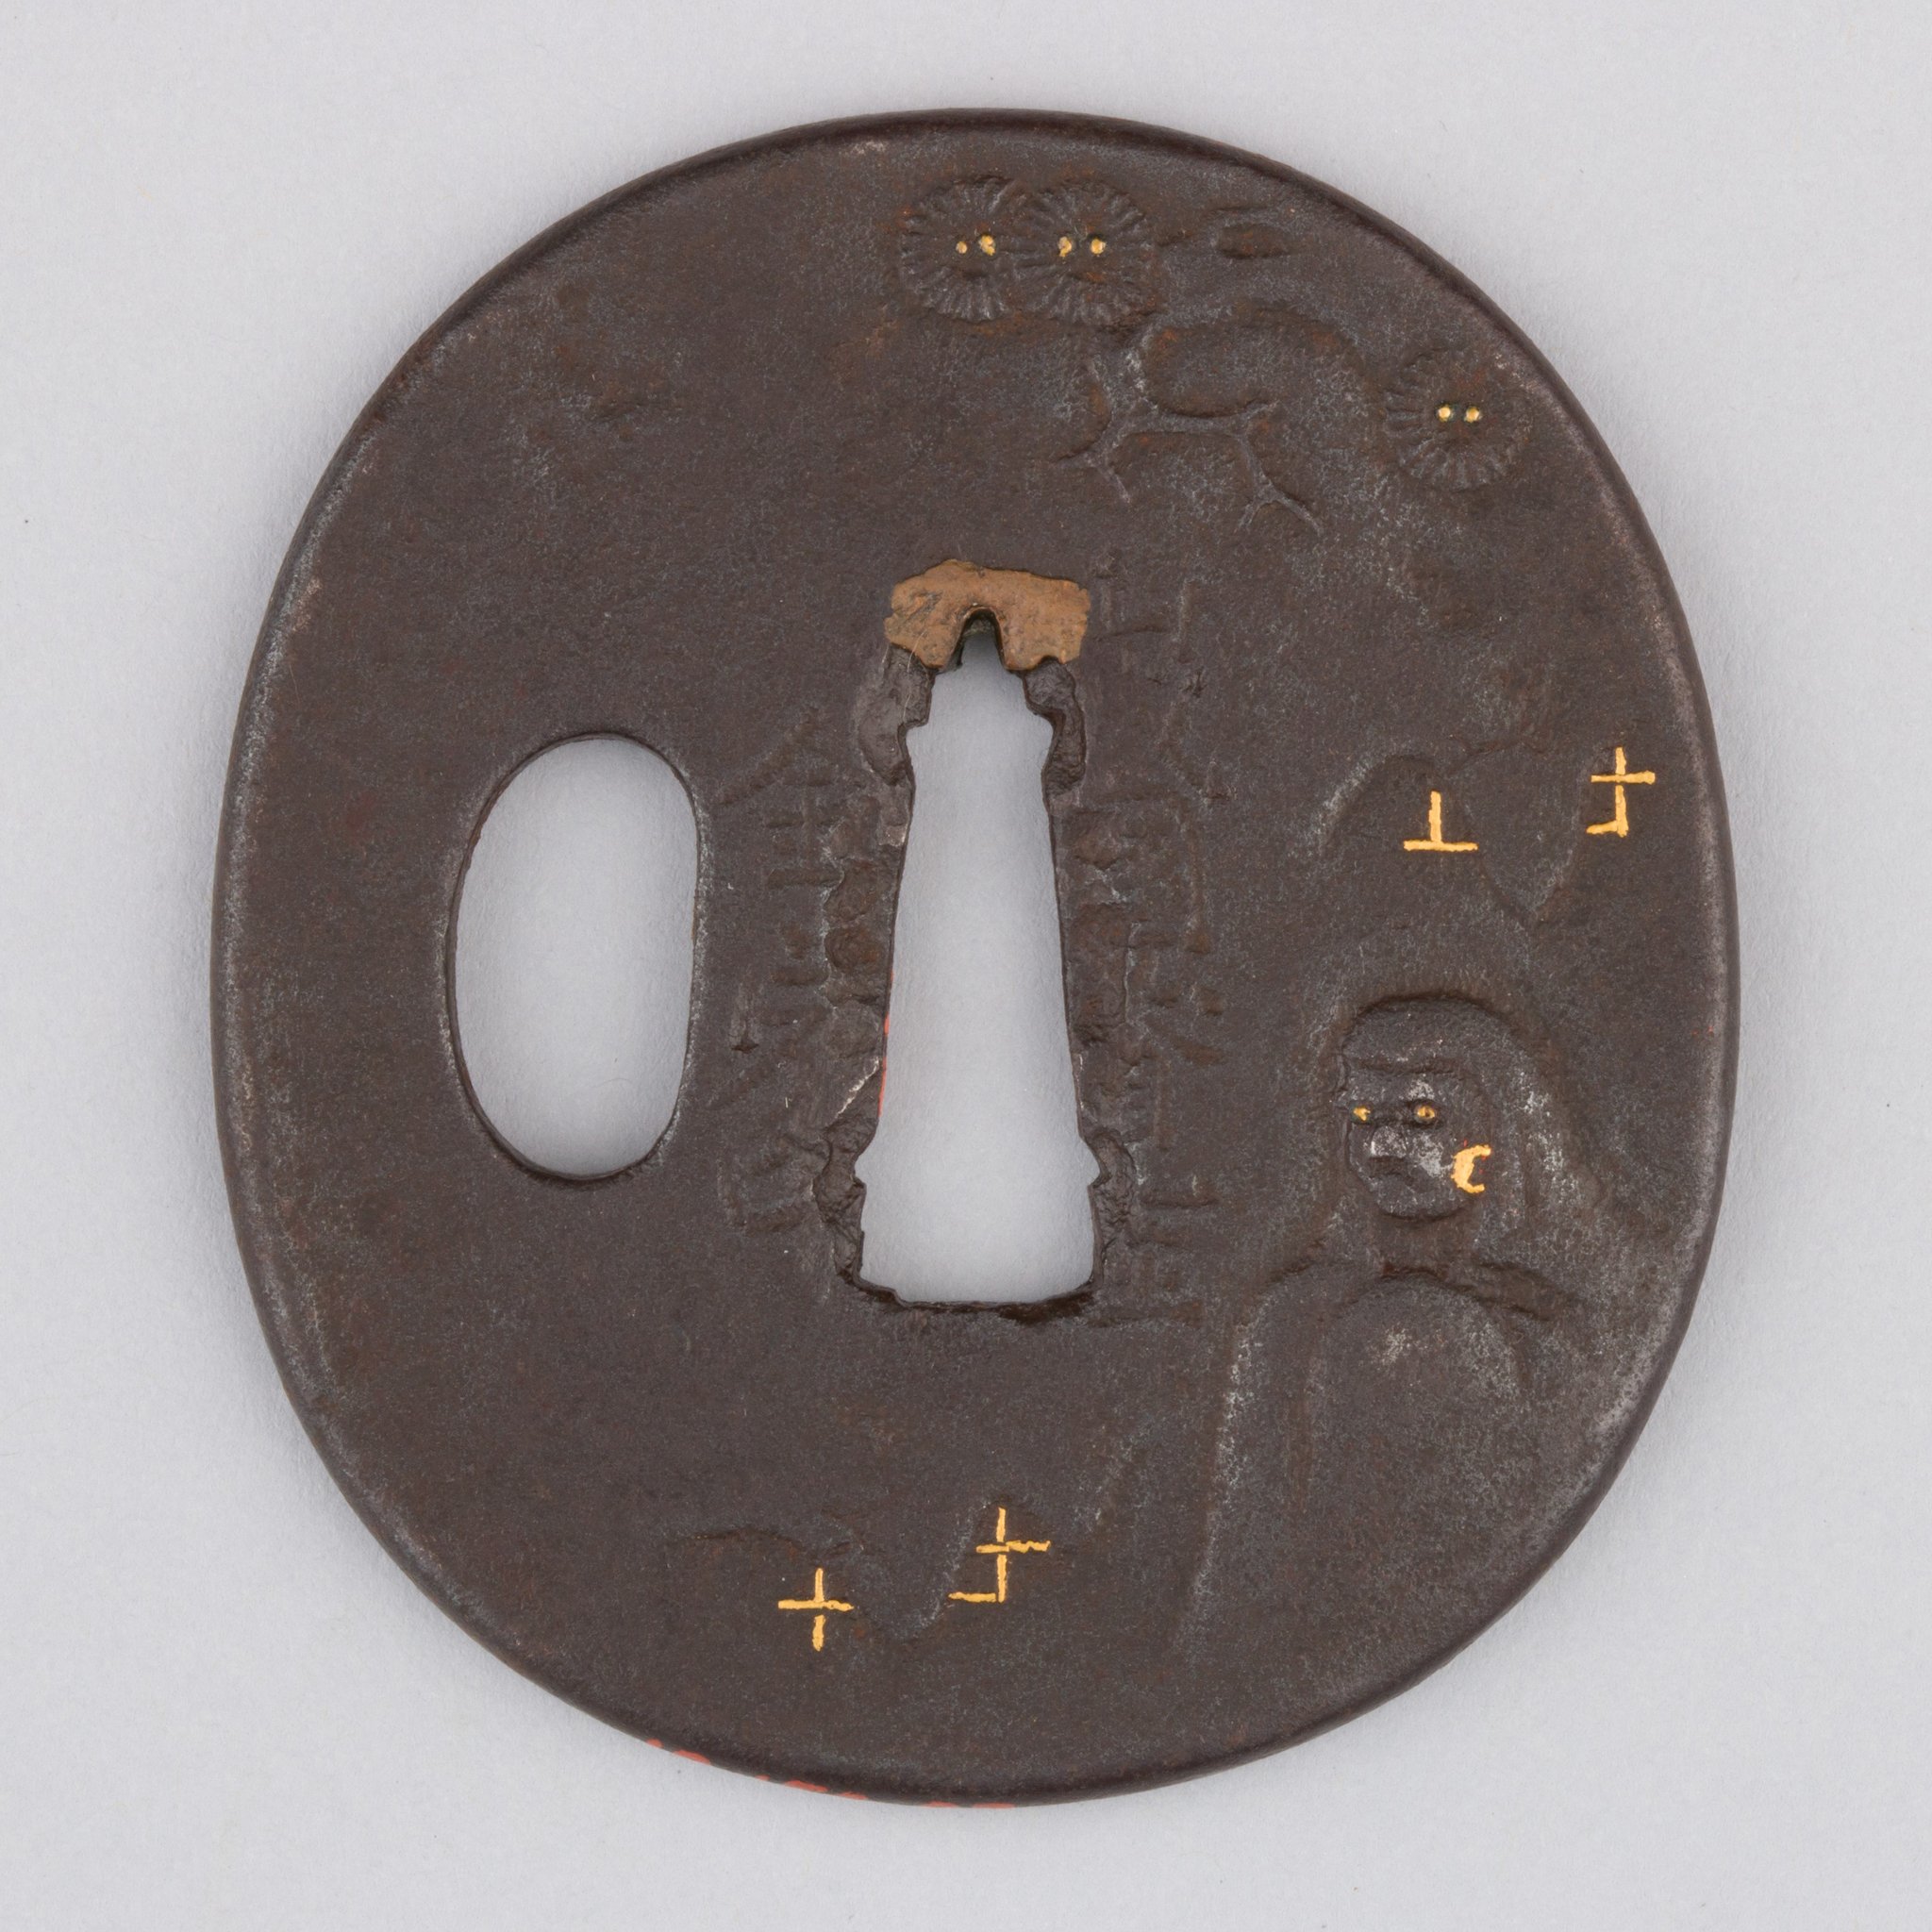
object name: sword guard tsuba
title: Sword Guard (Tsuba)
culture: japanese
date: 1615-1868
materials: copper, iron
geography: japan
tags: men